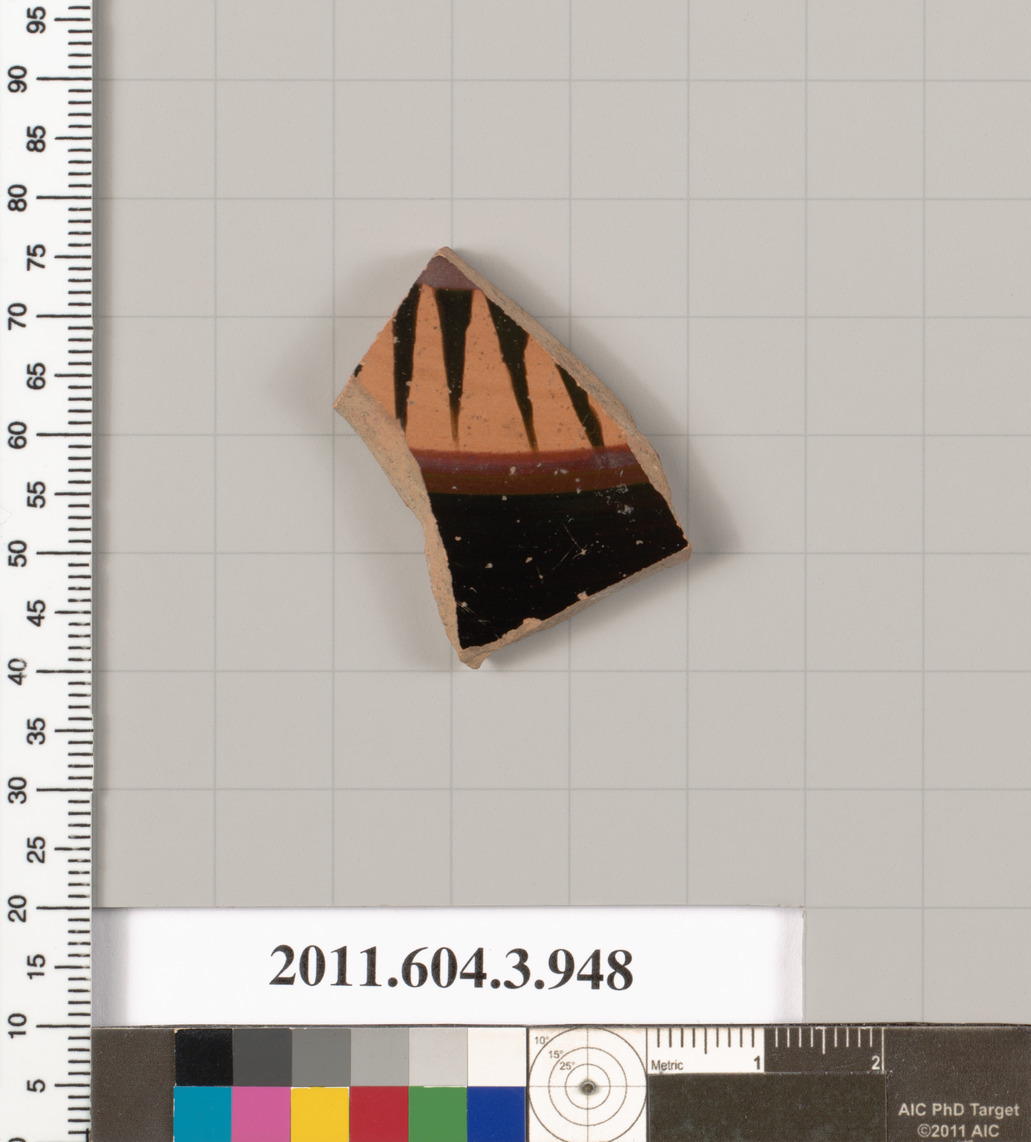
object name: lekanis lid fragment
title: Terracotta fragment of a lekanis lid (covered dish)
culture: greek, attic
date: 600-501 BCE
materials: terracotta